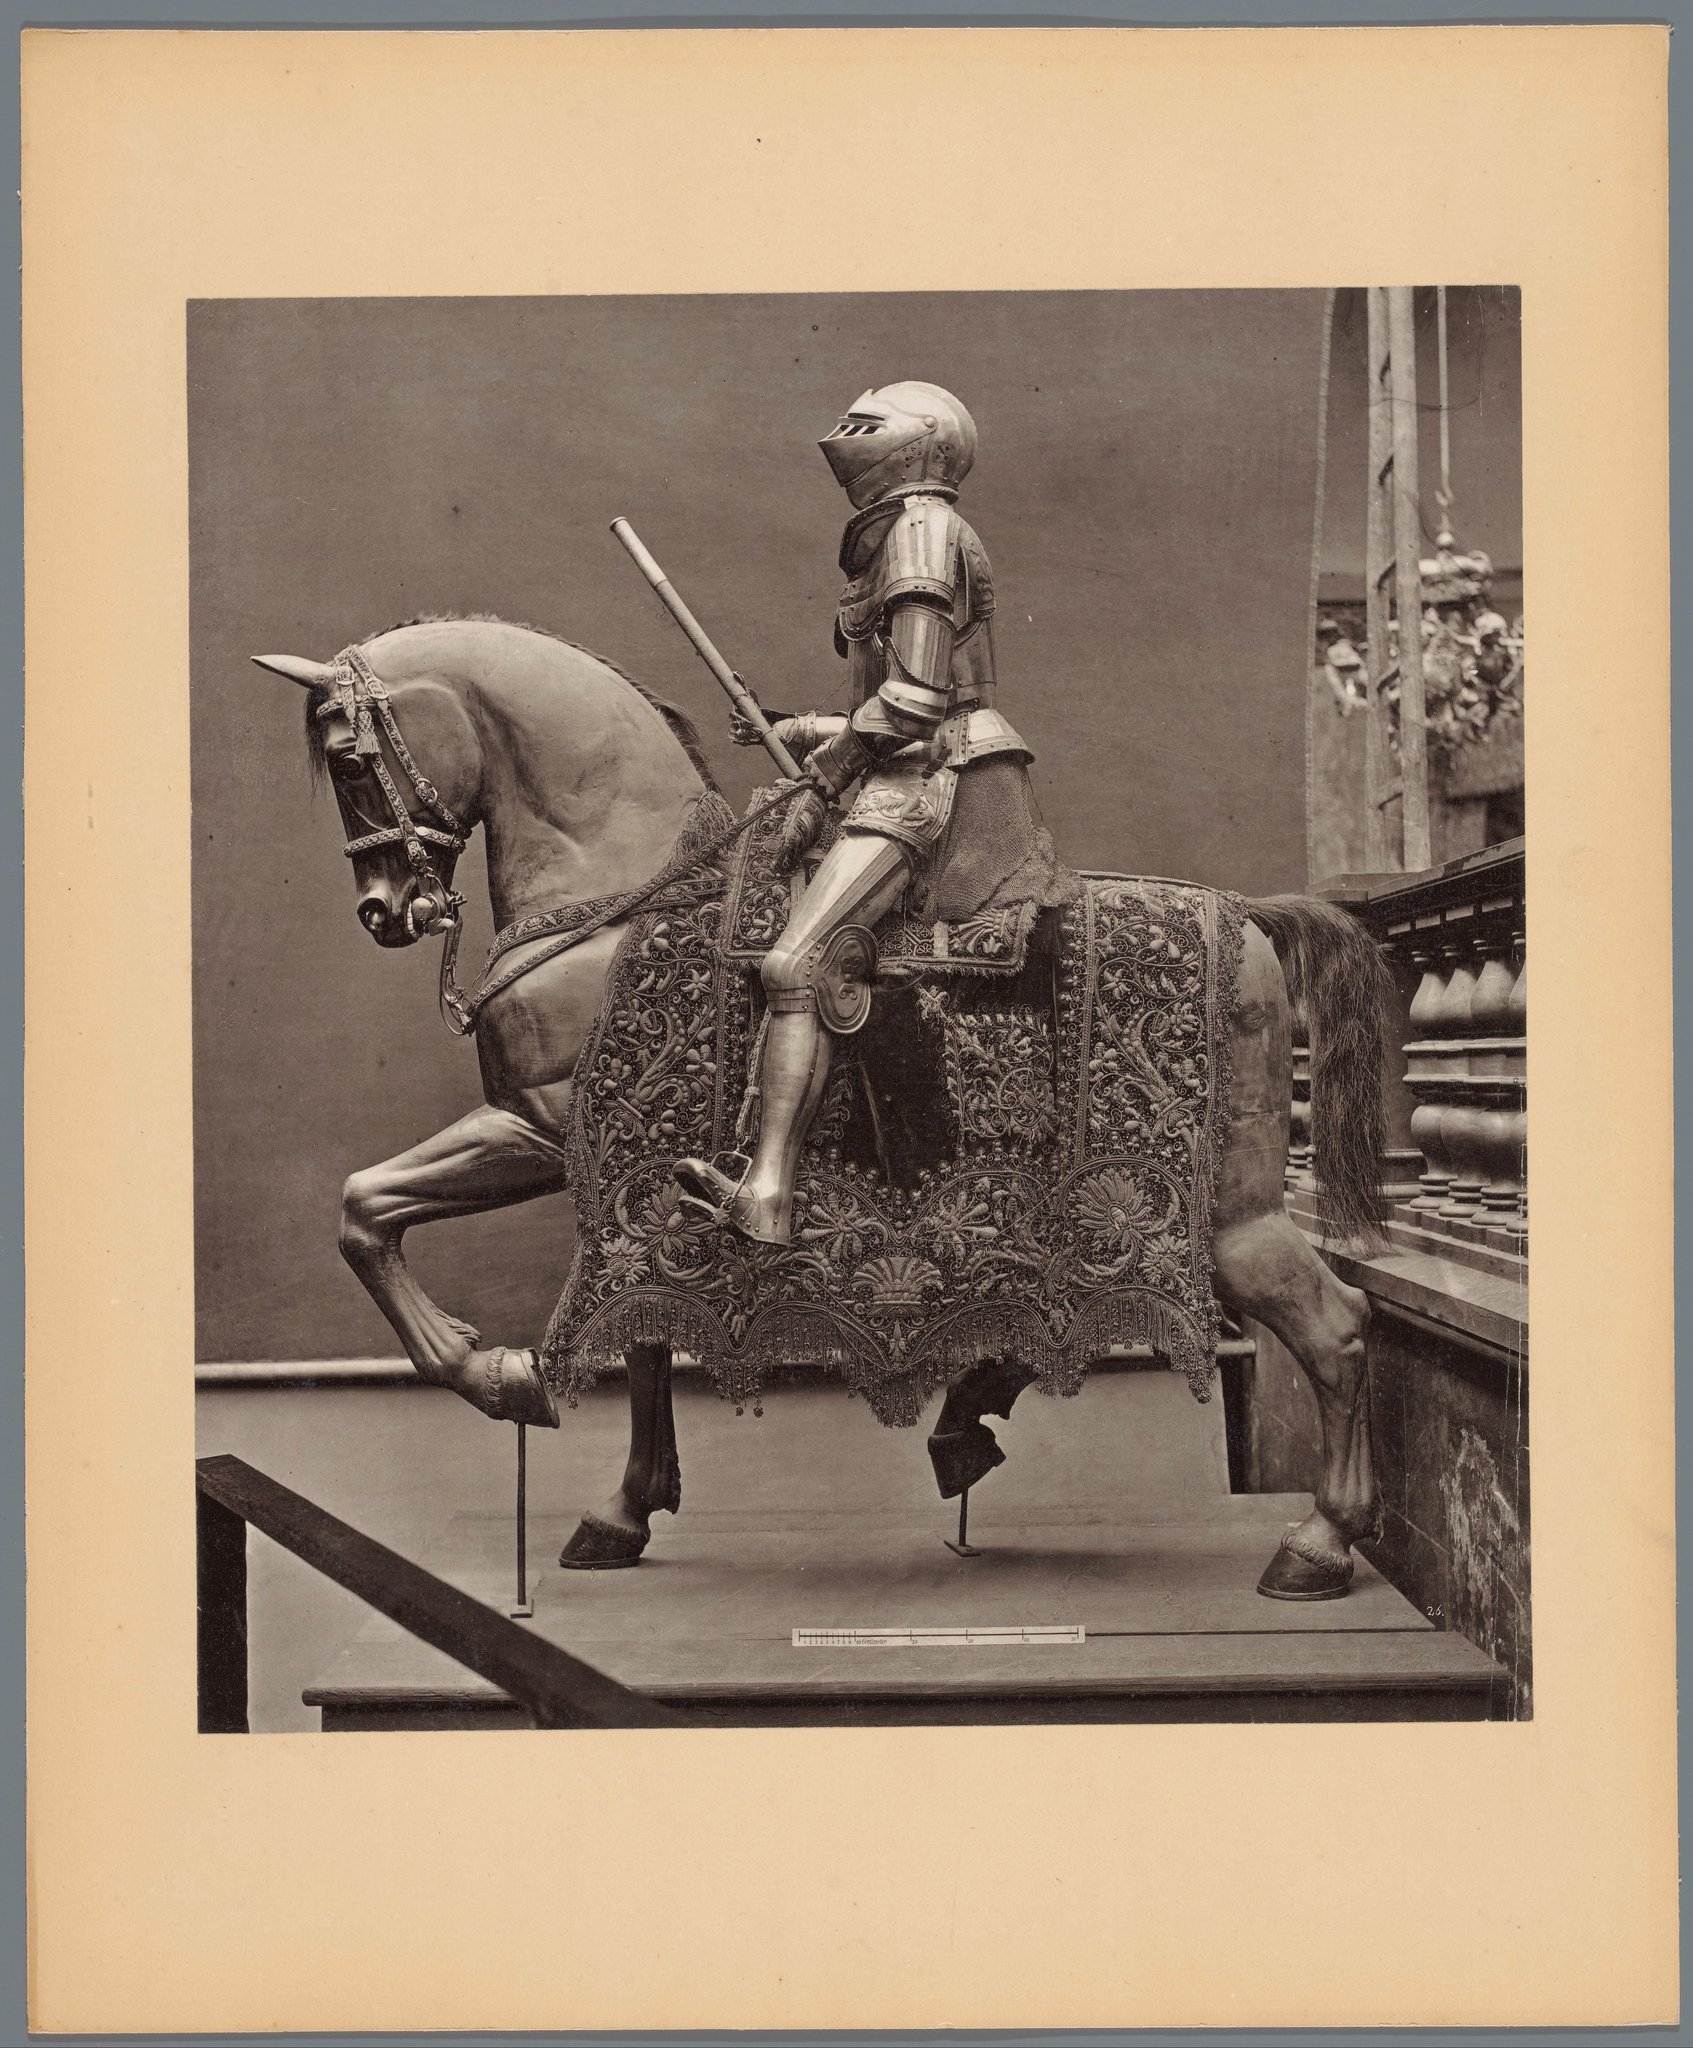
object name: photograph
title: Opstelling van een sculptuur van een paard met daarop een zadel van textiel en een harnas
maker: Anonymous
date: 1875-1900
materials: cardboard, paper, ink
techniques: photograph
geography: europe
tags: armour, saddle, horse, europe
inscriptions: number: ‘26.’, collector's mark: Lugt 3937